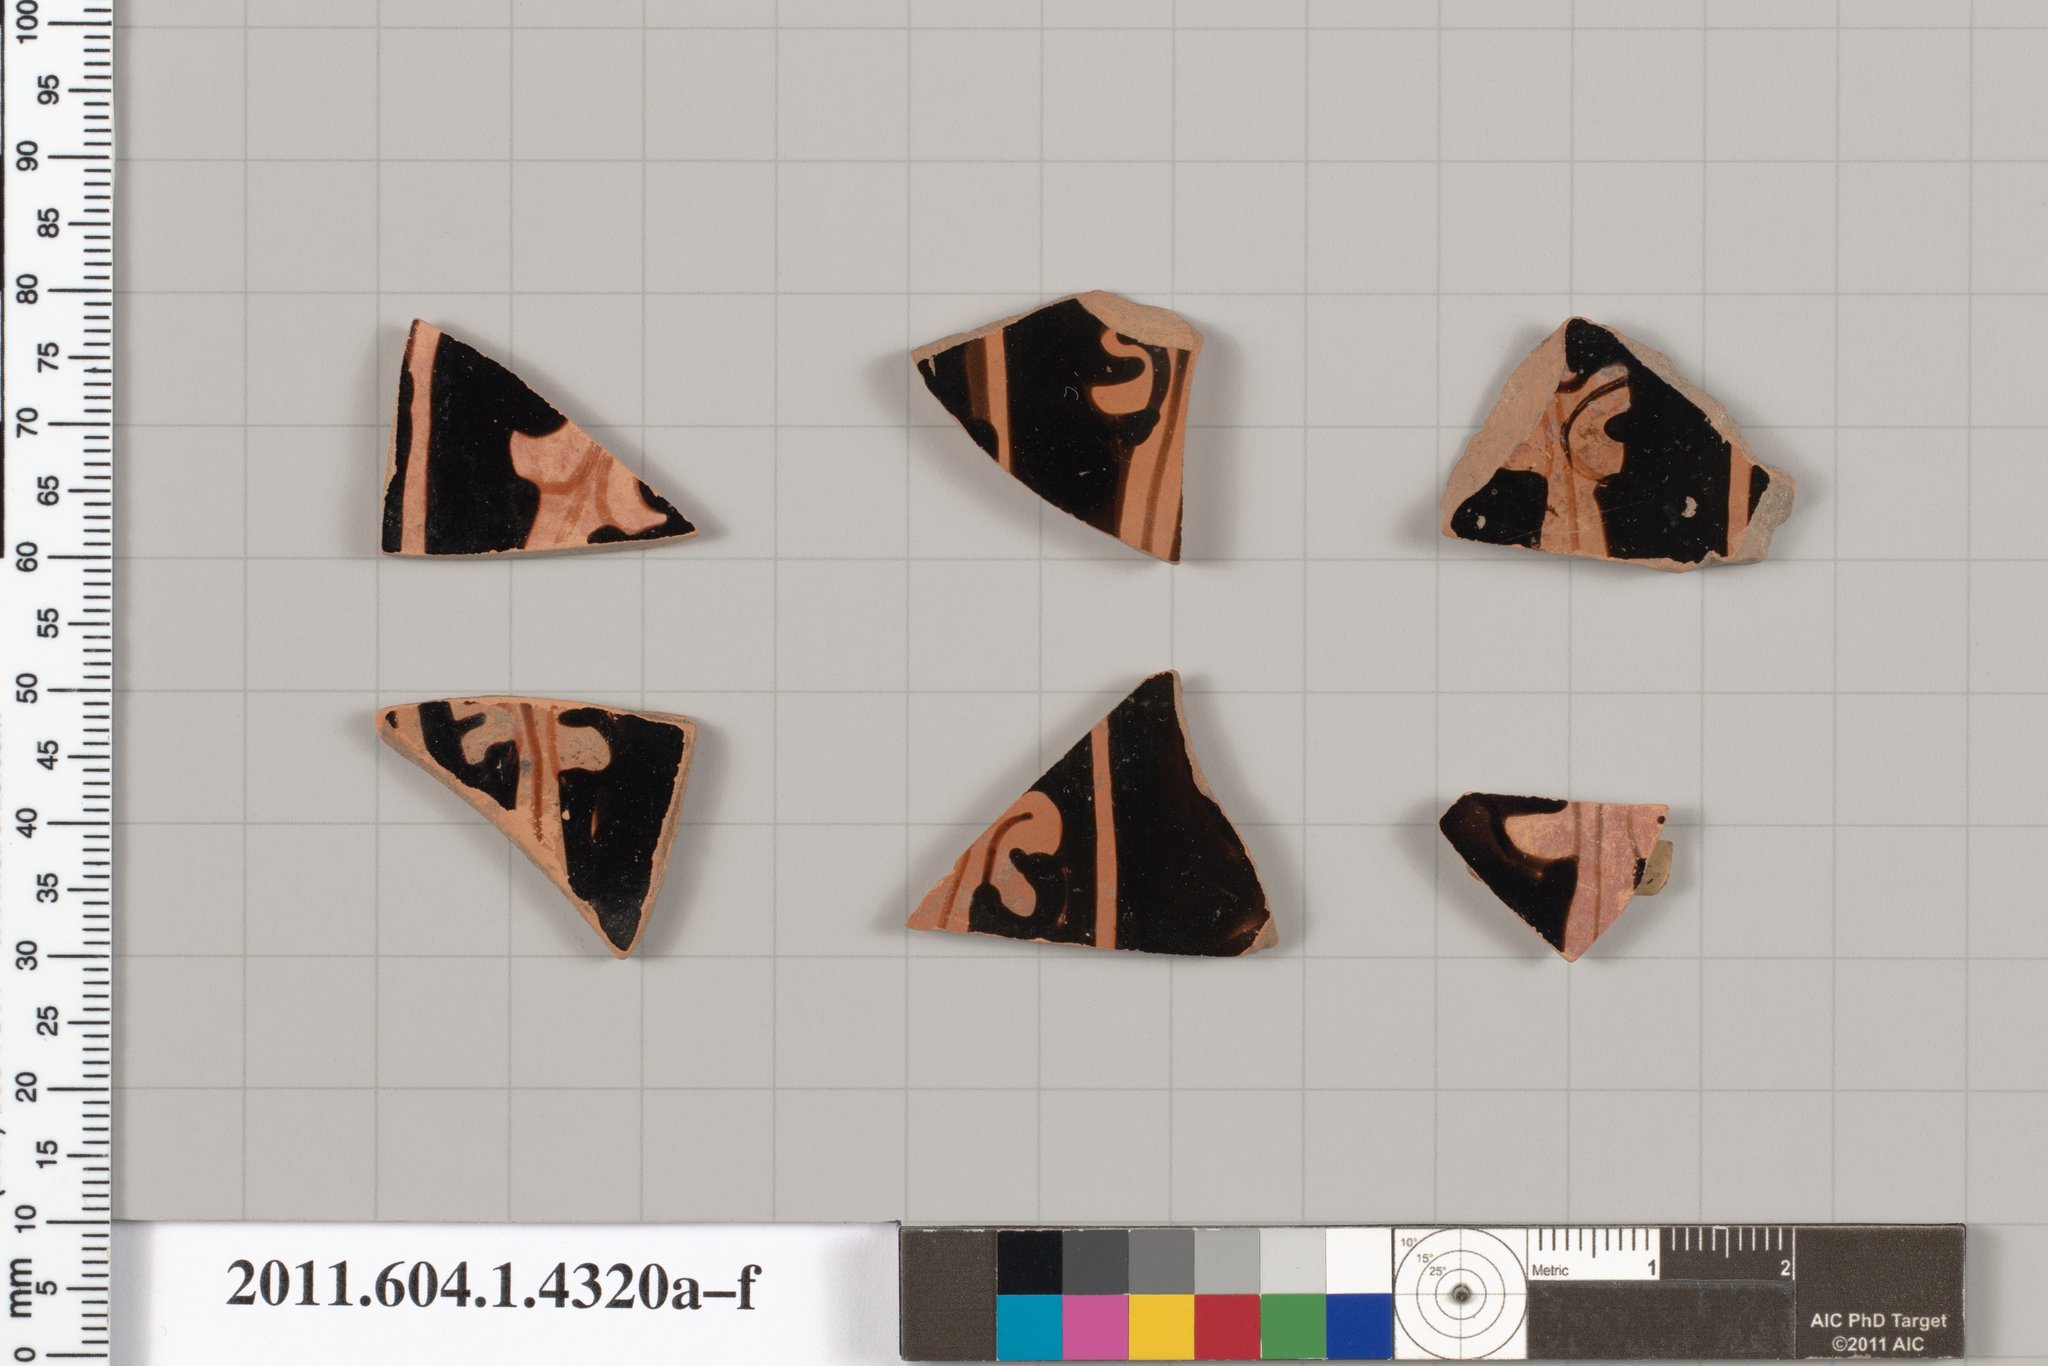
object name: kylix fragment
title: Terracotta fragments of kylikes (drinking cups)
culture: greek, attic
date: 475-451 BCE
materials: terracotta